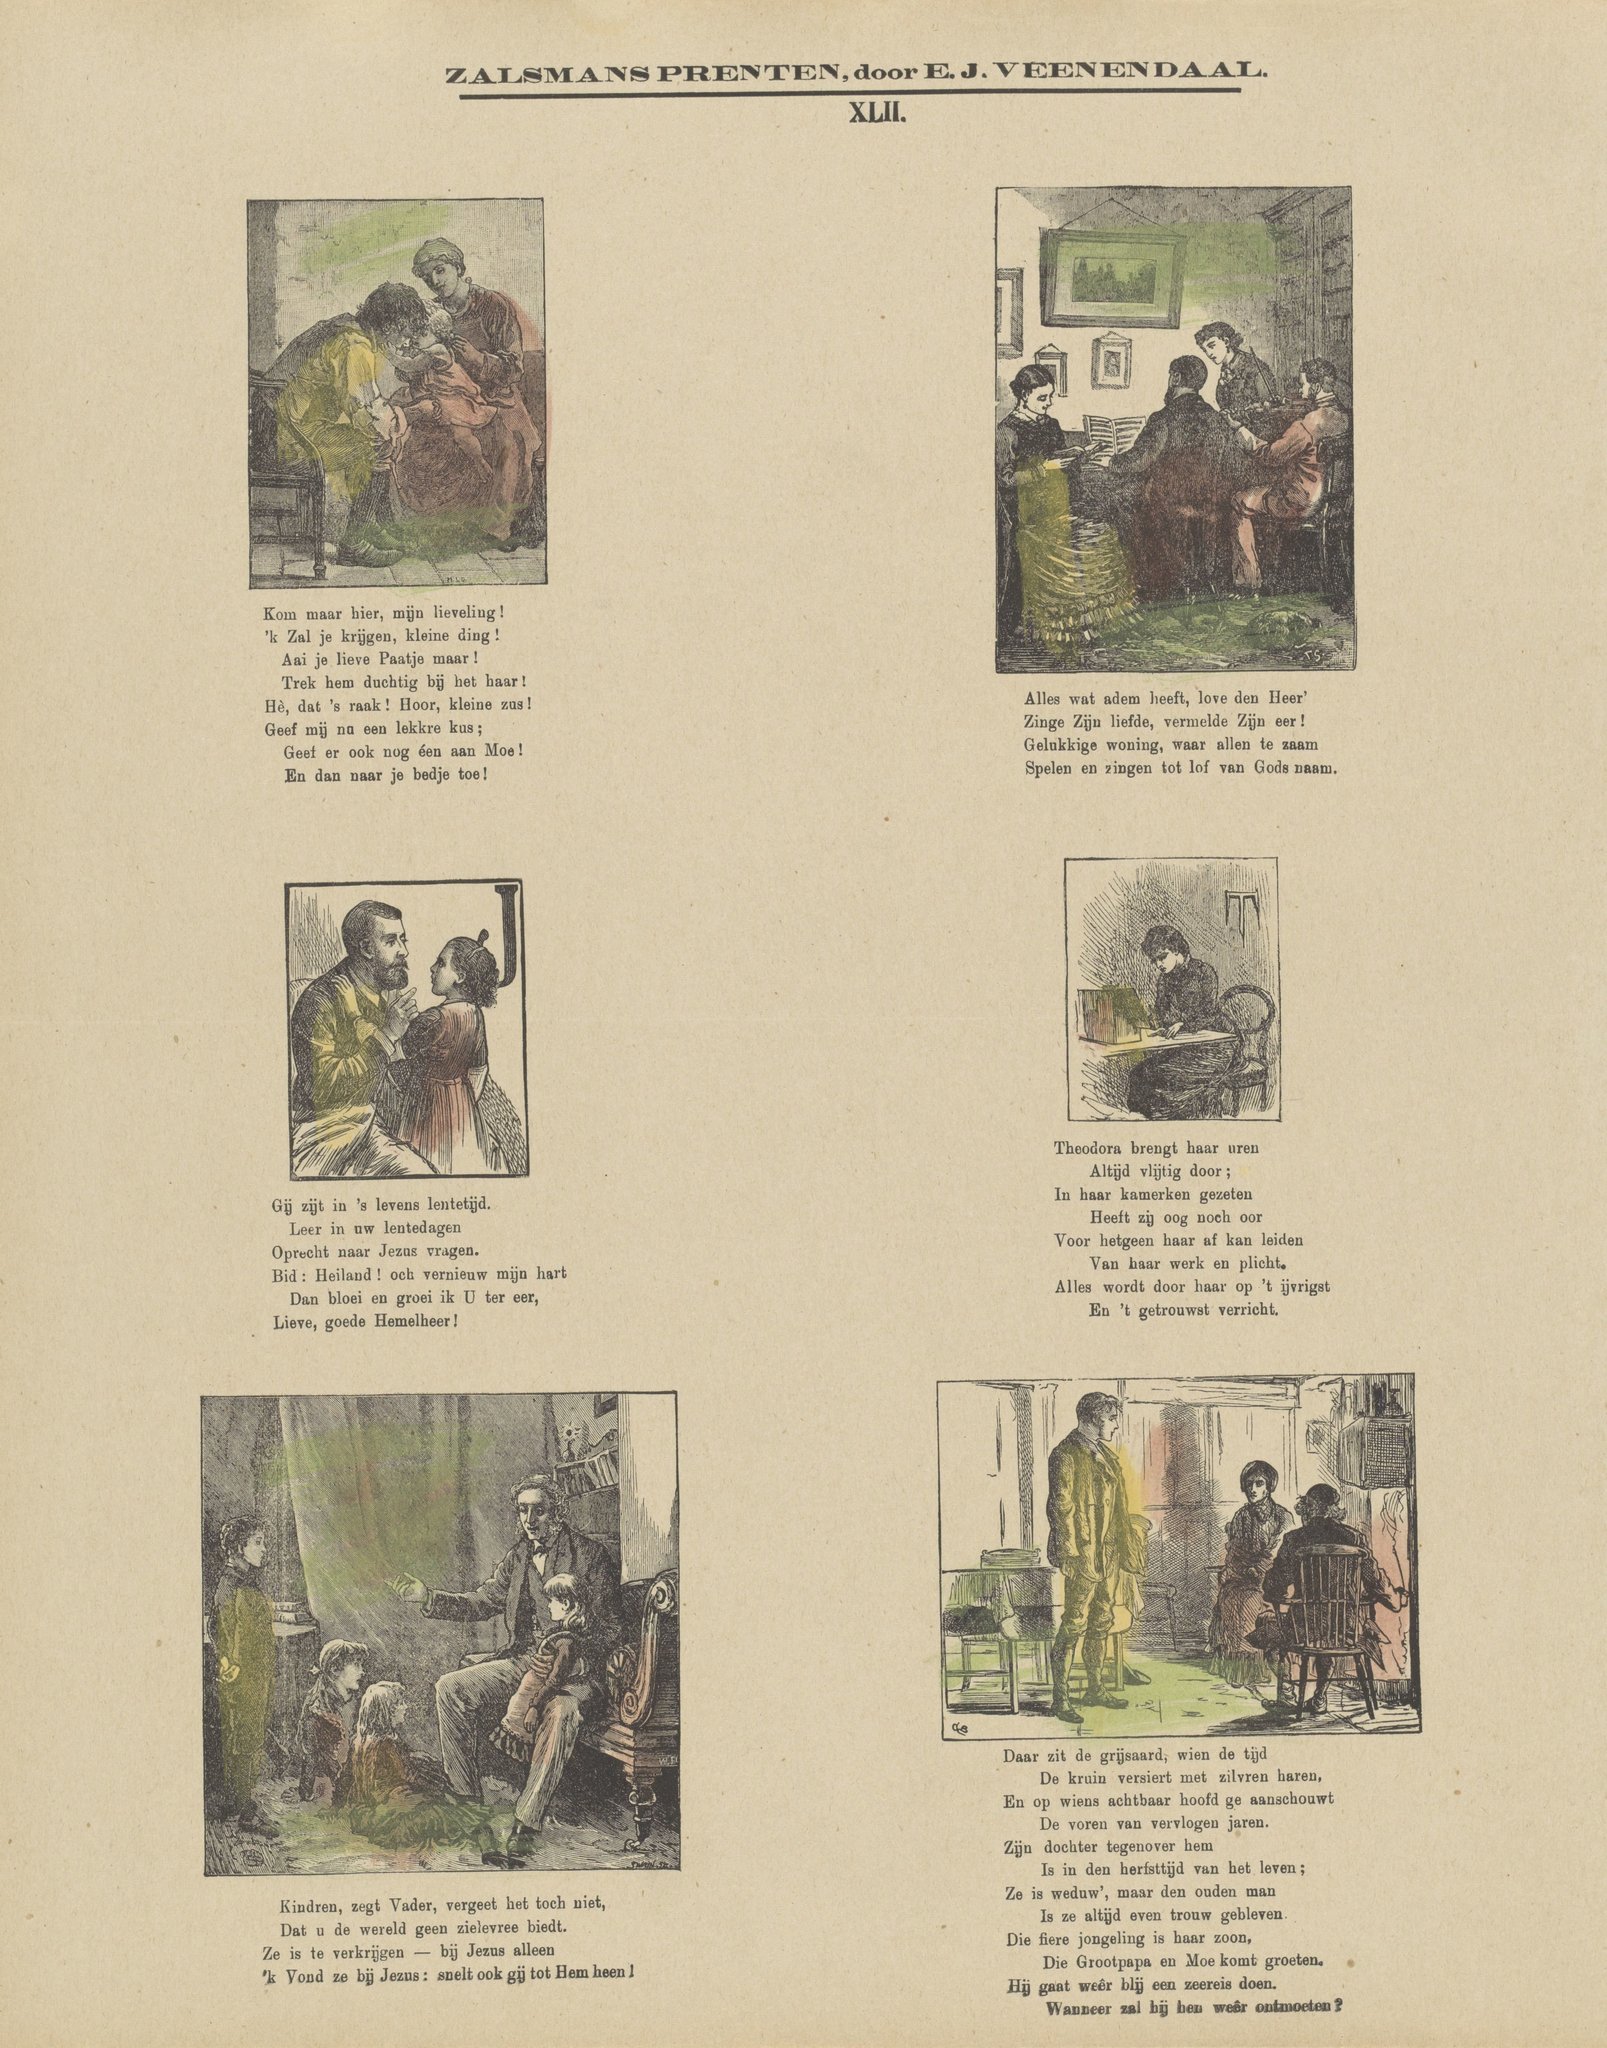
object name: popular print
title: Zalmans prenten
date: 1869-1882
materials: paper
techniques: colour, letterpress printing, engraving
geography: europe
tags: father with son(s) and daughter(s) (father-love), child, family, descendance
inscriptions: collector's mark: Lugt 2760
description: Blad met 6 taferelen met kinderen. Onder elke afbeelding een onderschrift. Genummerd midden boven: XLII.